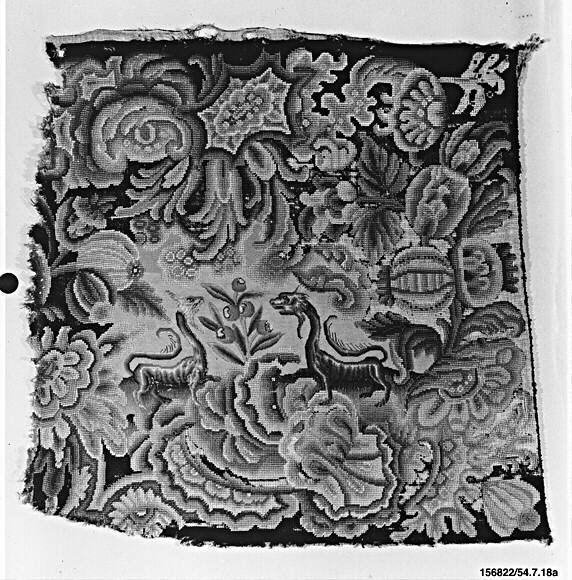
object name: upholstery panel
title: Chair seat and back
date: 1667-1733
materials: canvas, silk, wool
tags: mythical creatures,flowers